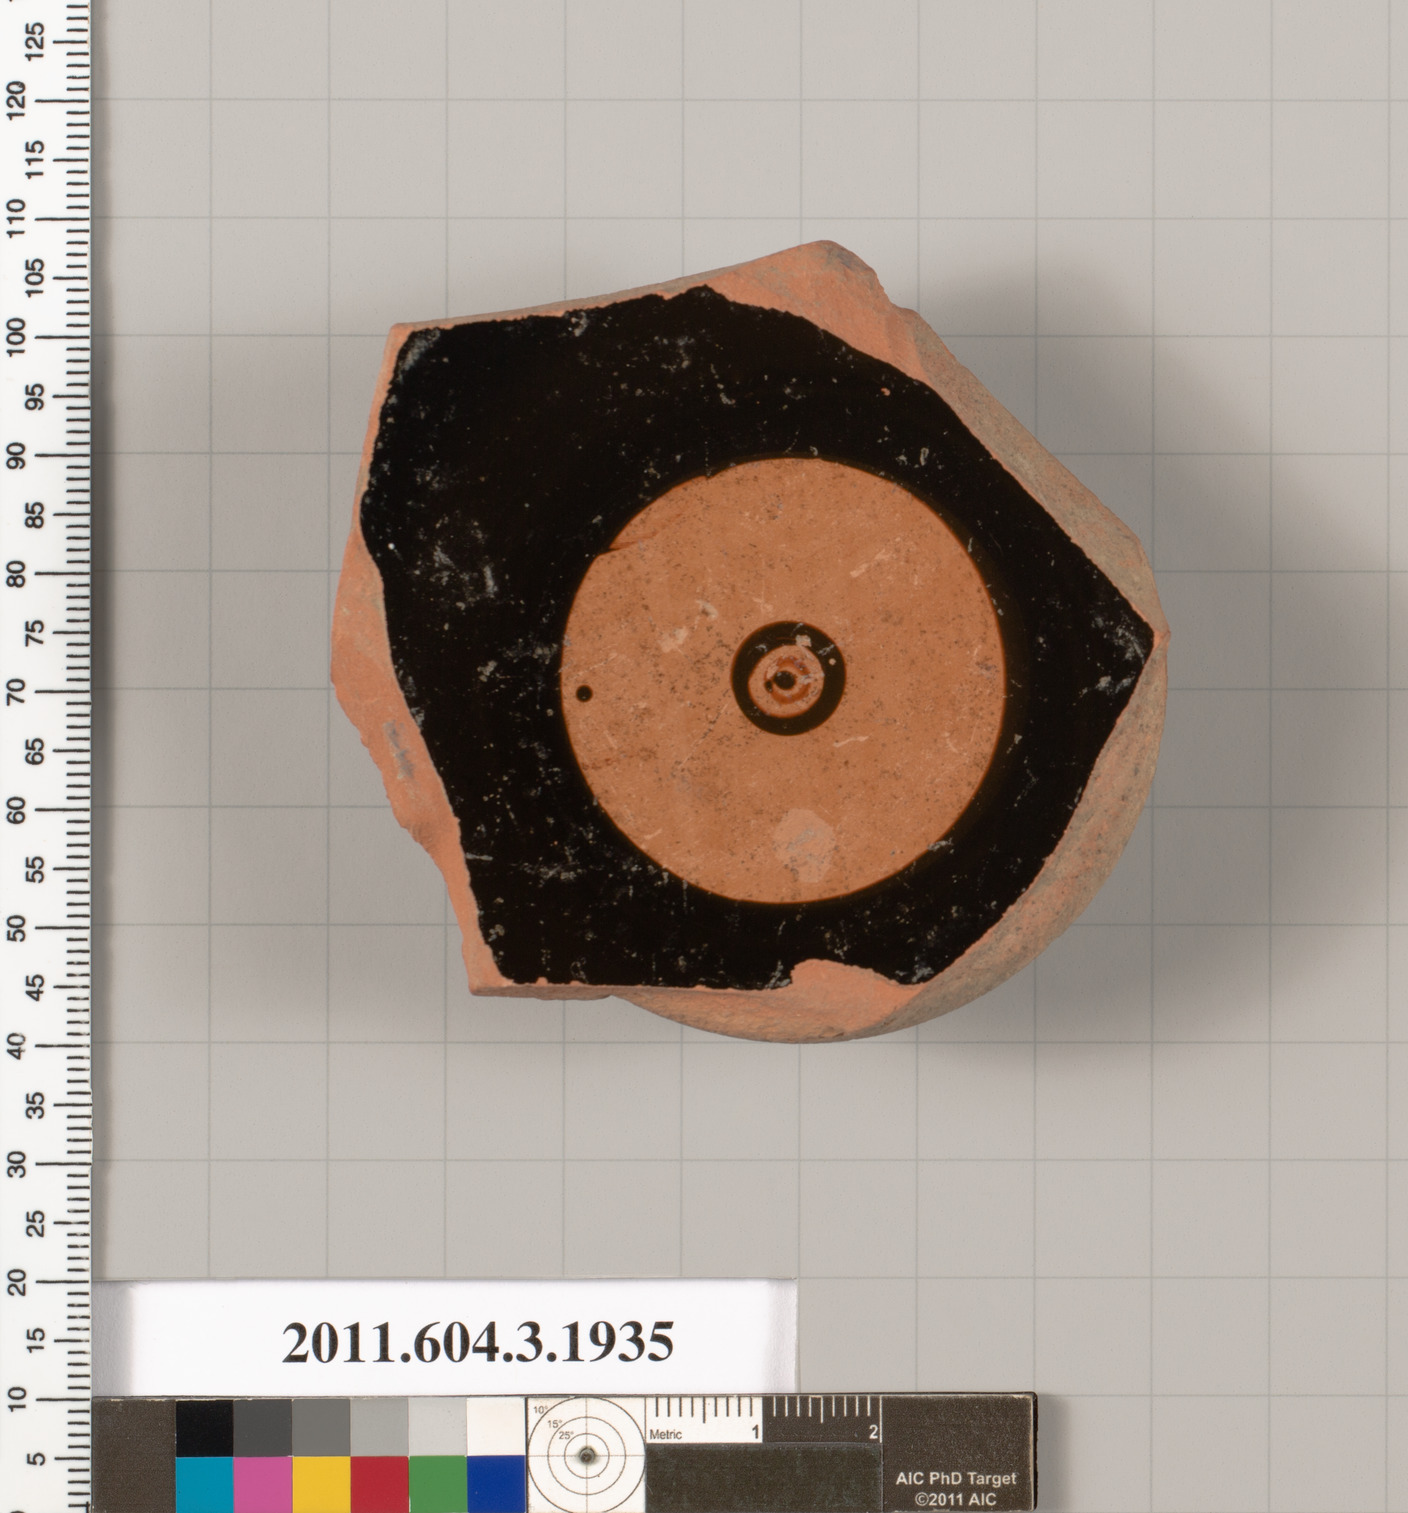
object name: kylix fragment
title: Terracotta fragment of a kylix (drinking cup)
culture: greek, attic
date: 540-500 BCE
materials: terracotta